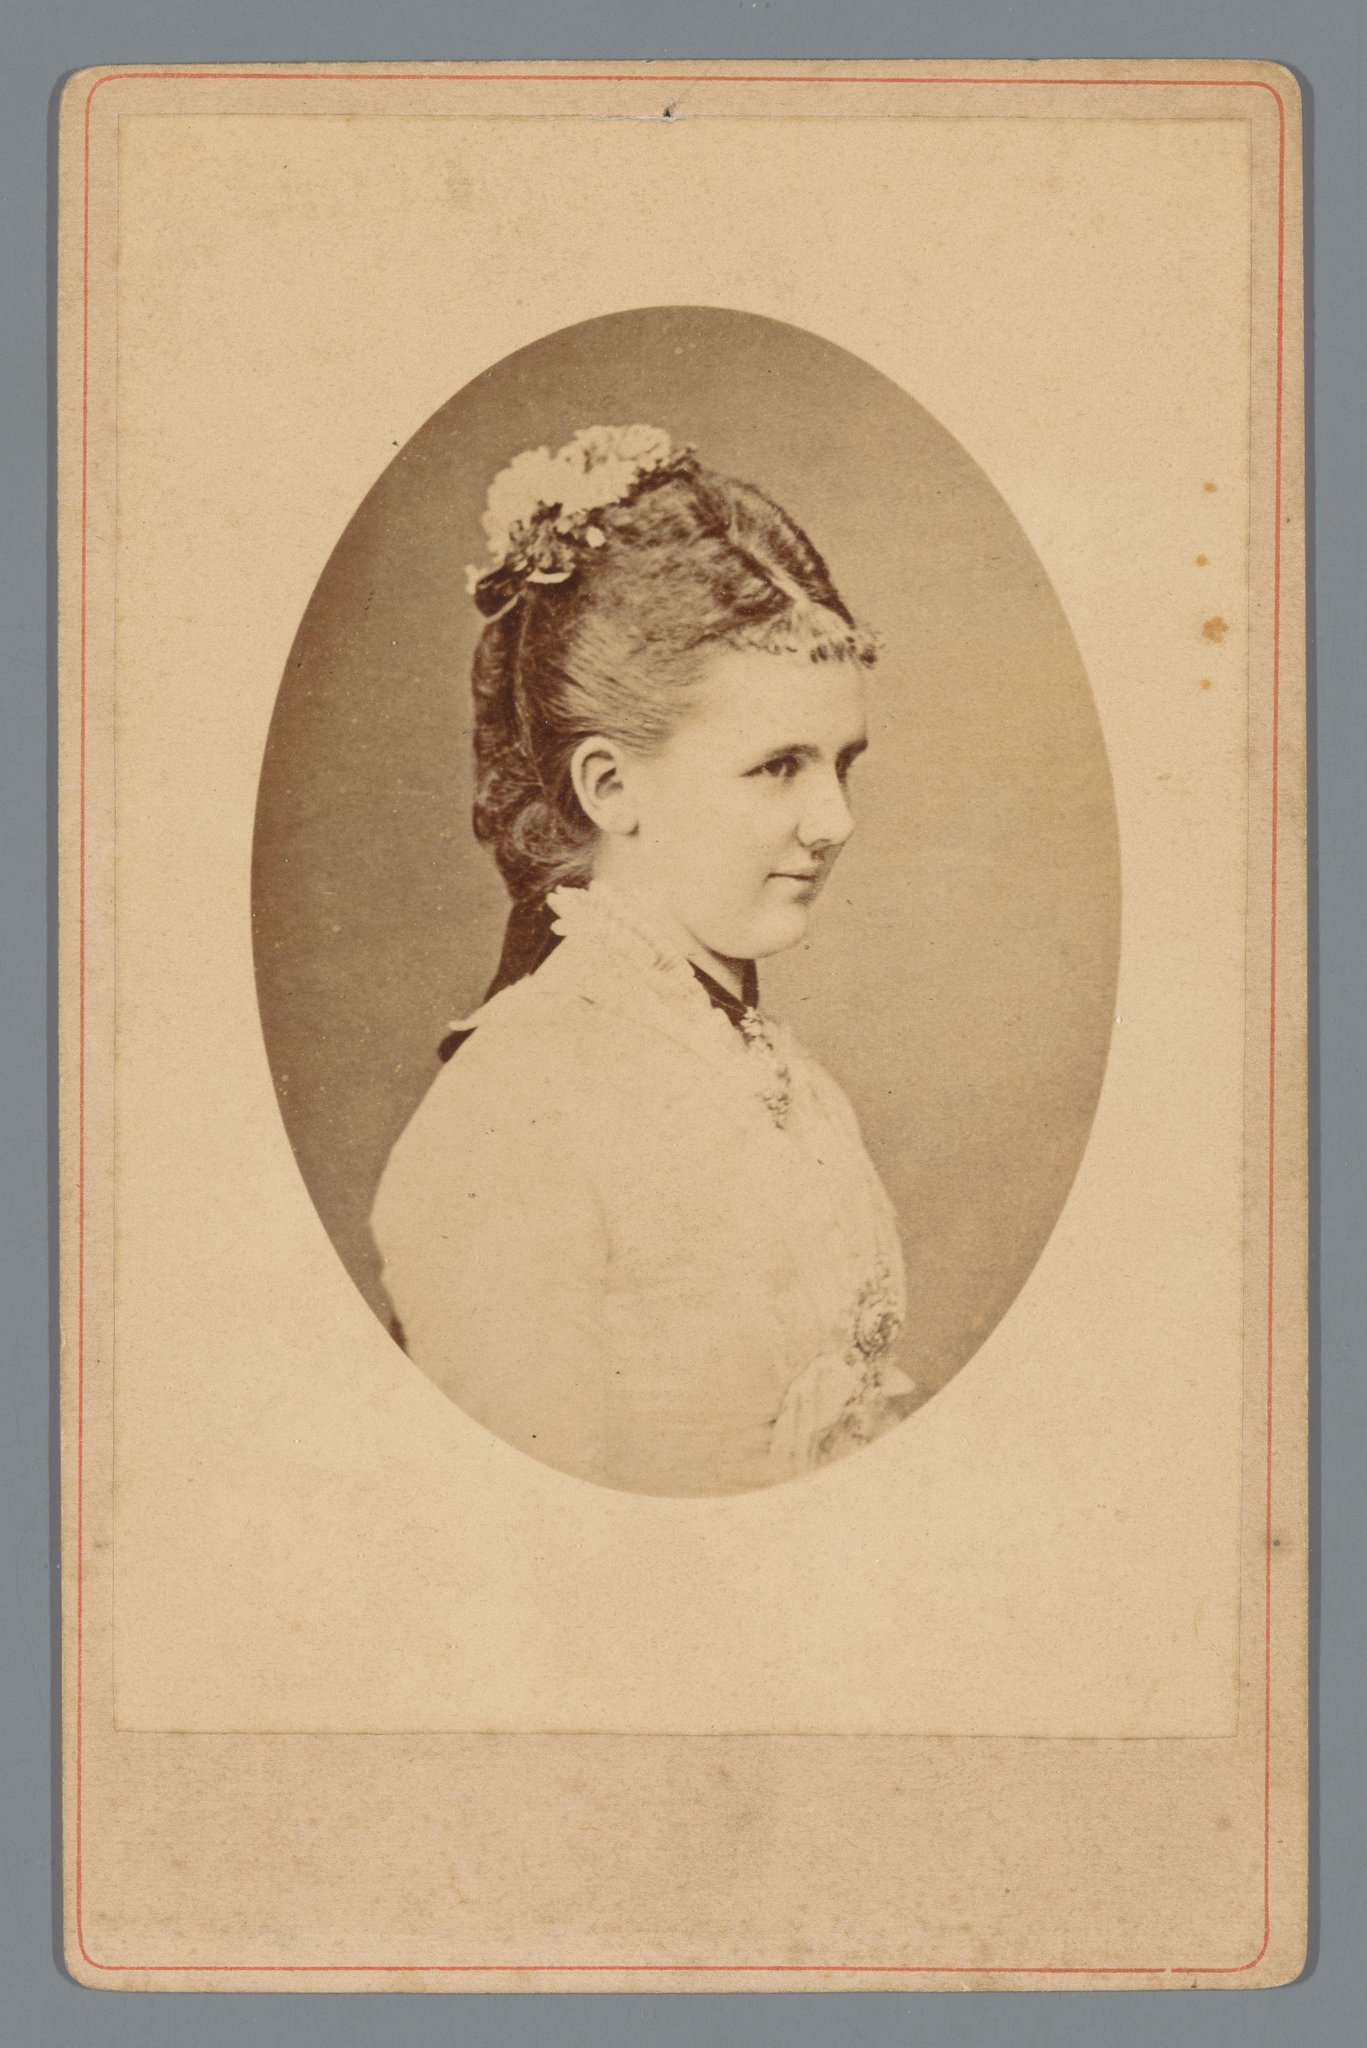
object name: cabinet photograph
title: Portret van koningin Emma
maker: Anonymous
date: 1879-1890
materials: cardboard, paper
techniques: albumen print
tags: the hague, emma (queen consort of the netherlands), historical persons, princess